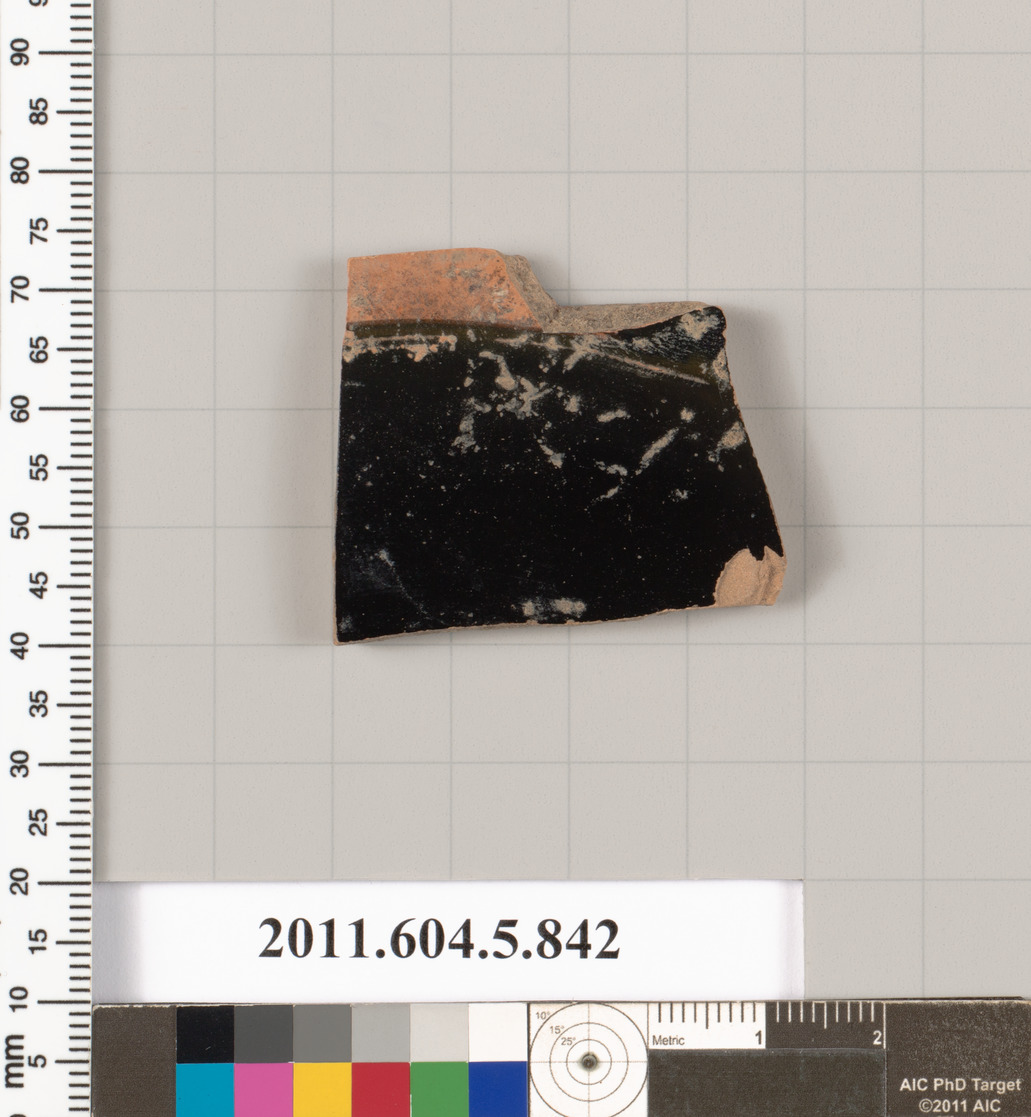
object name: kylix fragment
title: Terracotta fragment of a kylix (drinking cup)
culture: greek, attic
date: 600-401 BCE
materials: terracotta